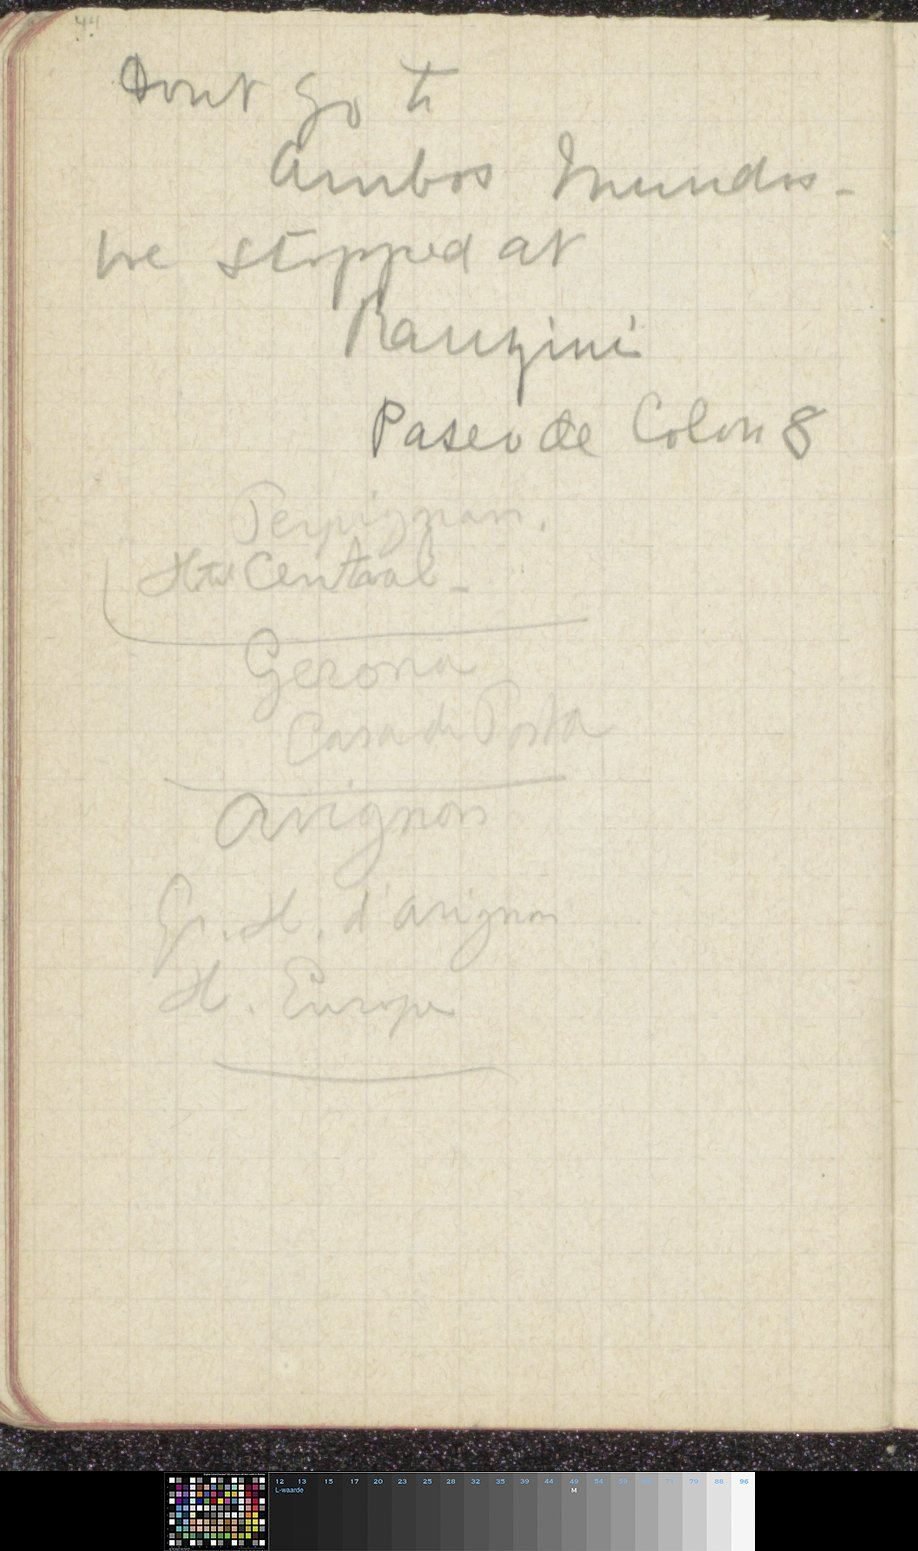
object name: sketchbook leaf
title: Notities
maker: marius bauer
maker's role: draughtsman, print maker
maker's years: 1867-1932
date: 1902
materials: pencil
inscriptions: annotation: ‘[...]/ ambros mundos./ [...] Rauzini/ Pasez de Colin 8/ Perpignan./ Htl Central./ Gerona Casa di posta/ Avignon/ [...]/ d'Avignon/ H. Europa’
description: Pagina 44 uit een schetsboek met 23 bladen.